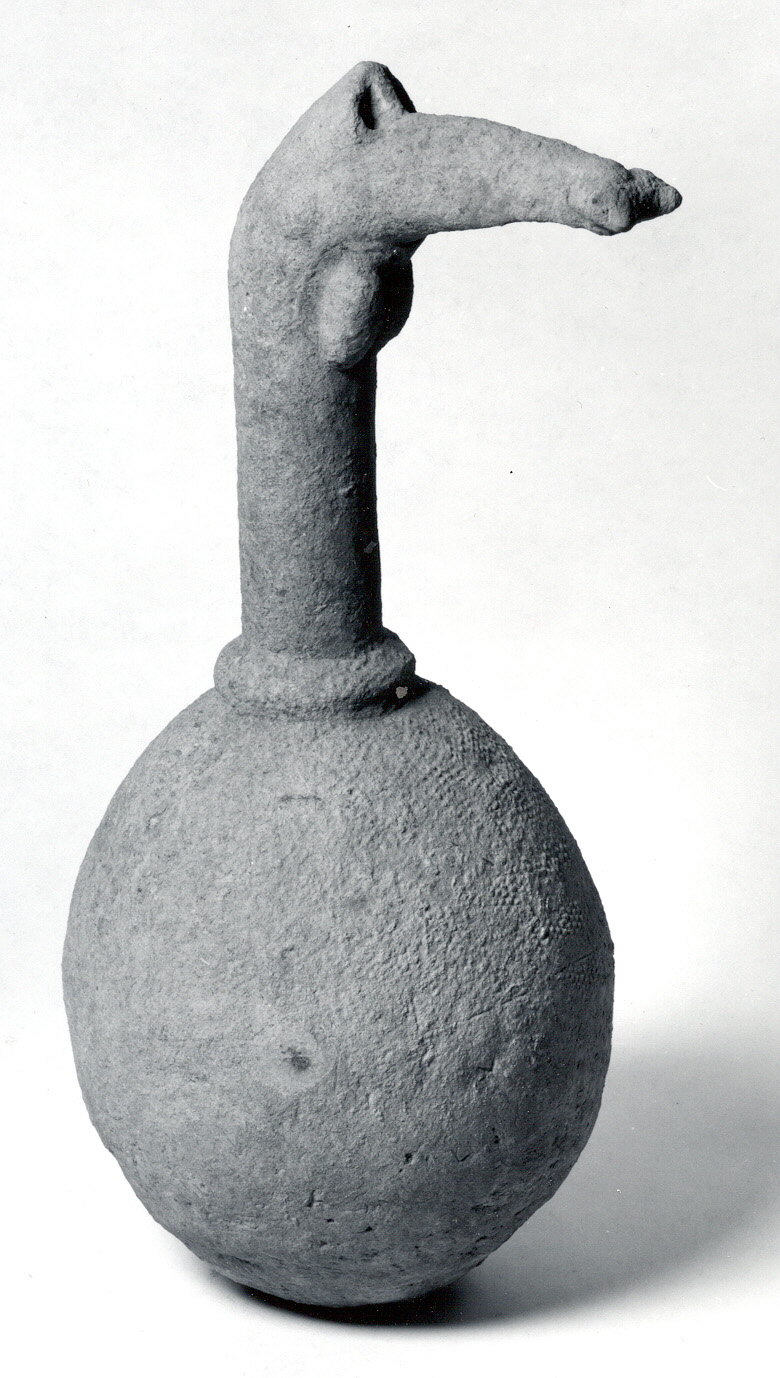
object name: vessel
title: Vessel: Zoomorphic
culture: middle niger civilization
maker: middle niger artist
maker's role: artist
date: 1101-1500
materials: terracotta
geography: mali